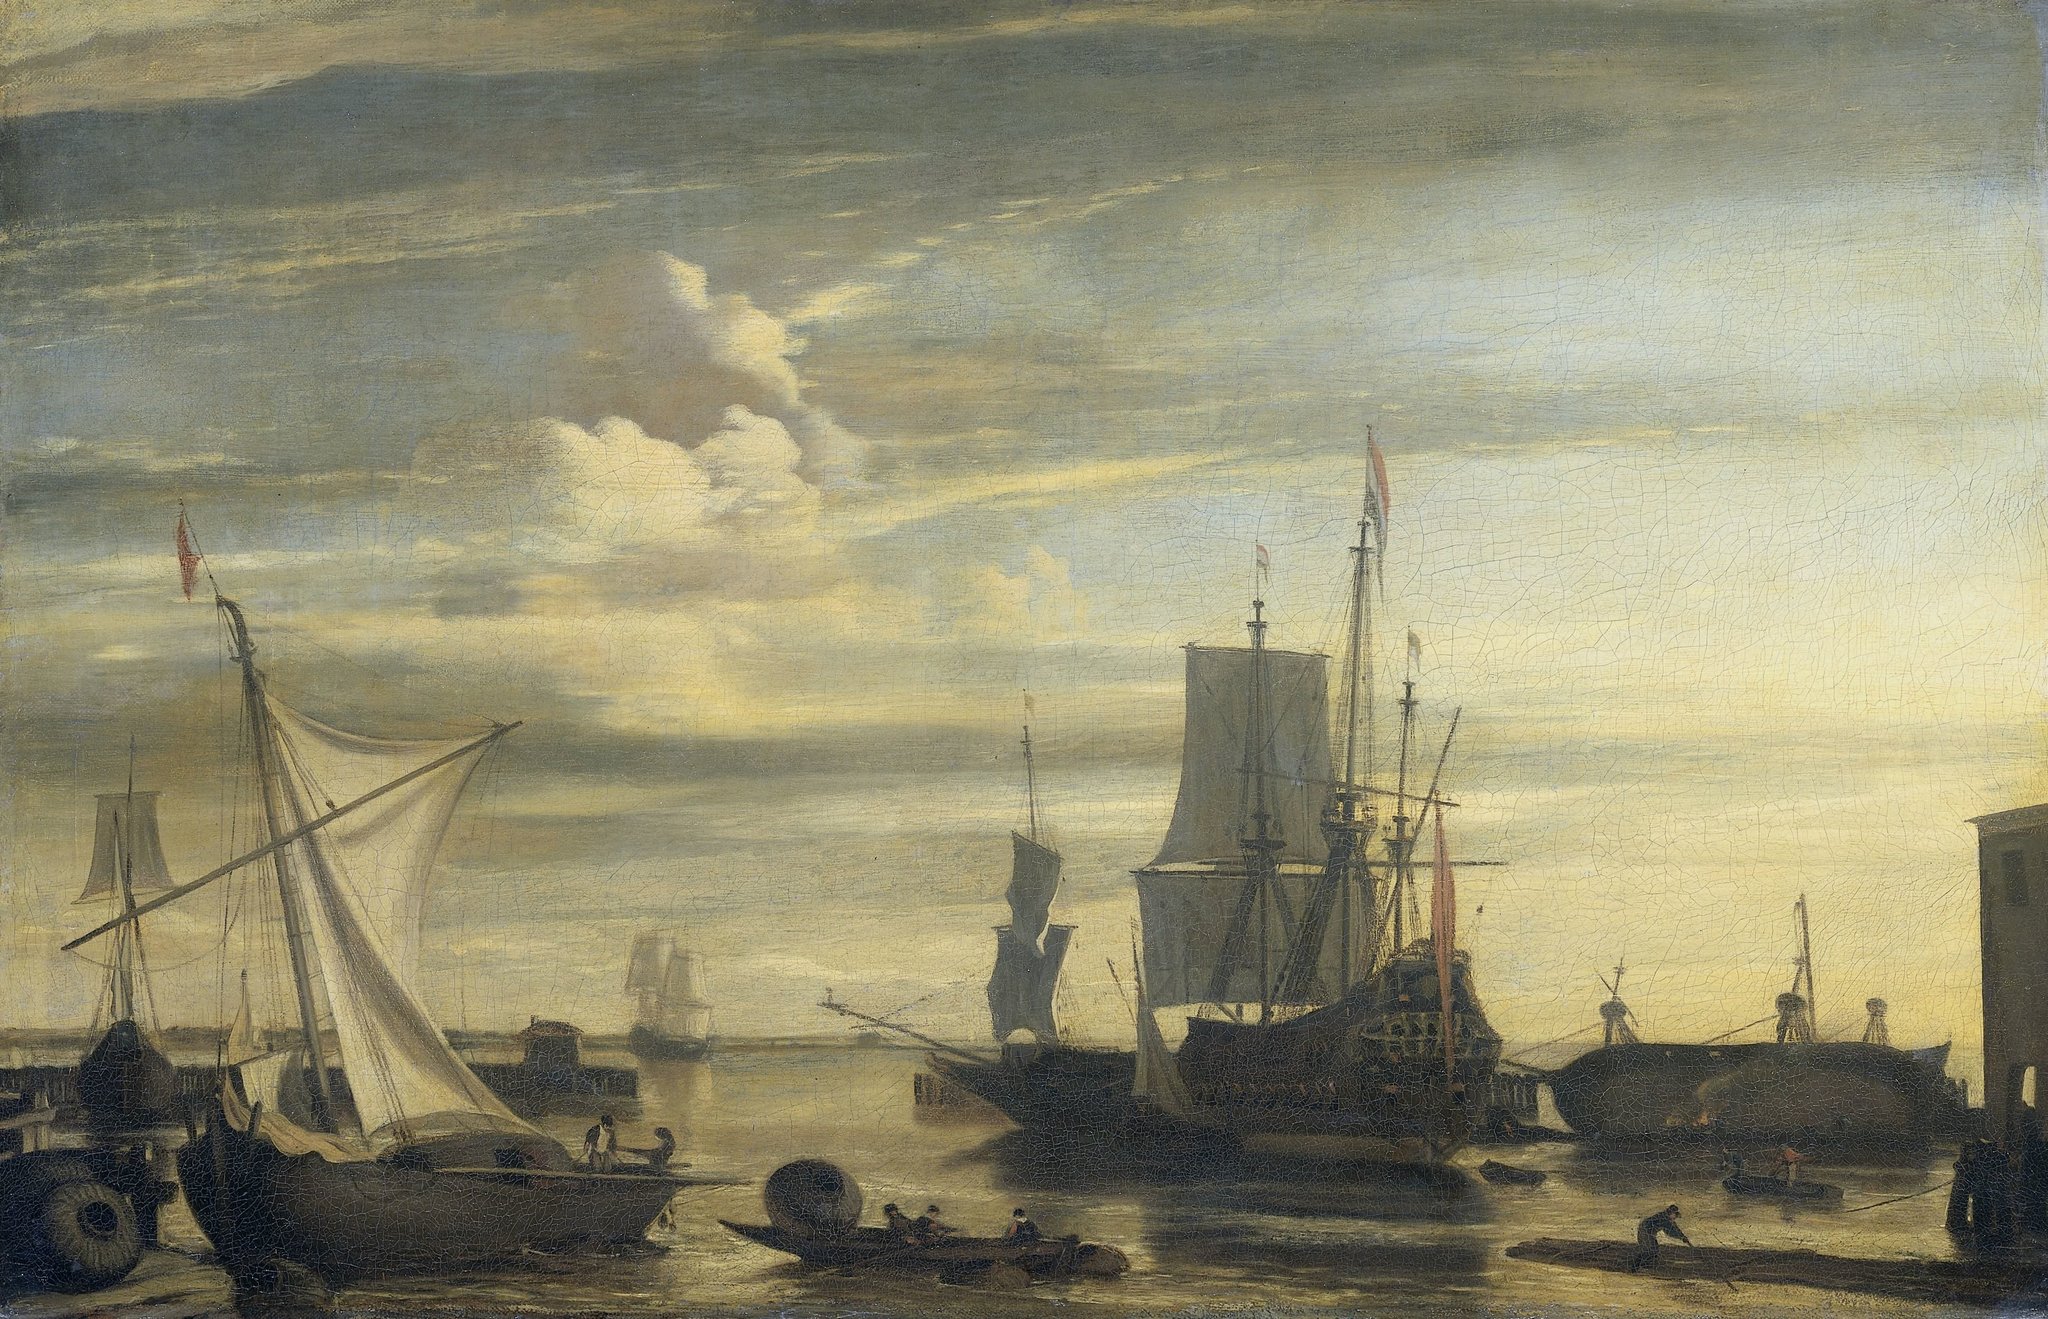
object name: painting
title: Harbor at Sunset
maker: jan claesz. rietschoof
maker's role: painter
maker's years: 1652-1719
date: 1675-1699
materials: canvas, oil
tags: harbour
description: Gezicht in een haven bij zonsondergang. In het midden een oorlogsschip, rechts wordt een schip gekalefaterd of gekrengd. Op de voorgrond een vissersschip en enkele figuren in een roeiboot.